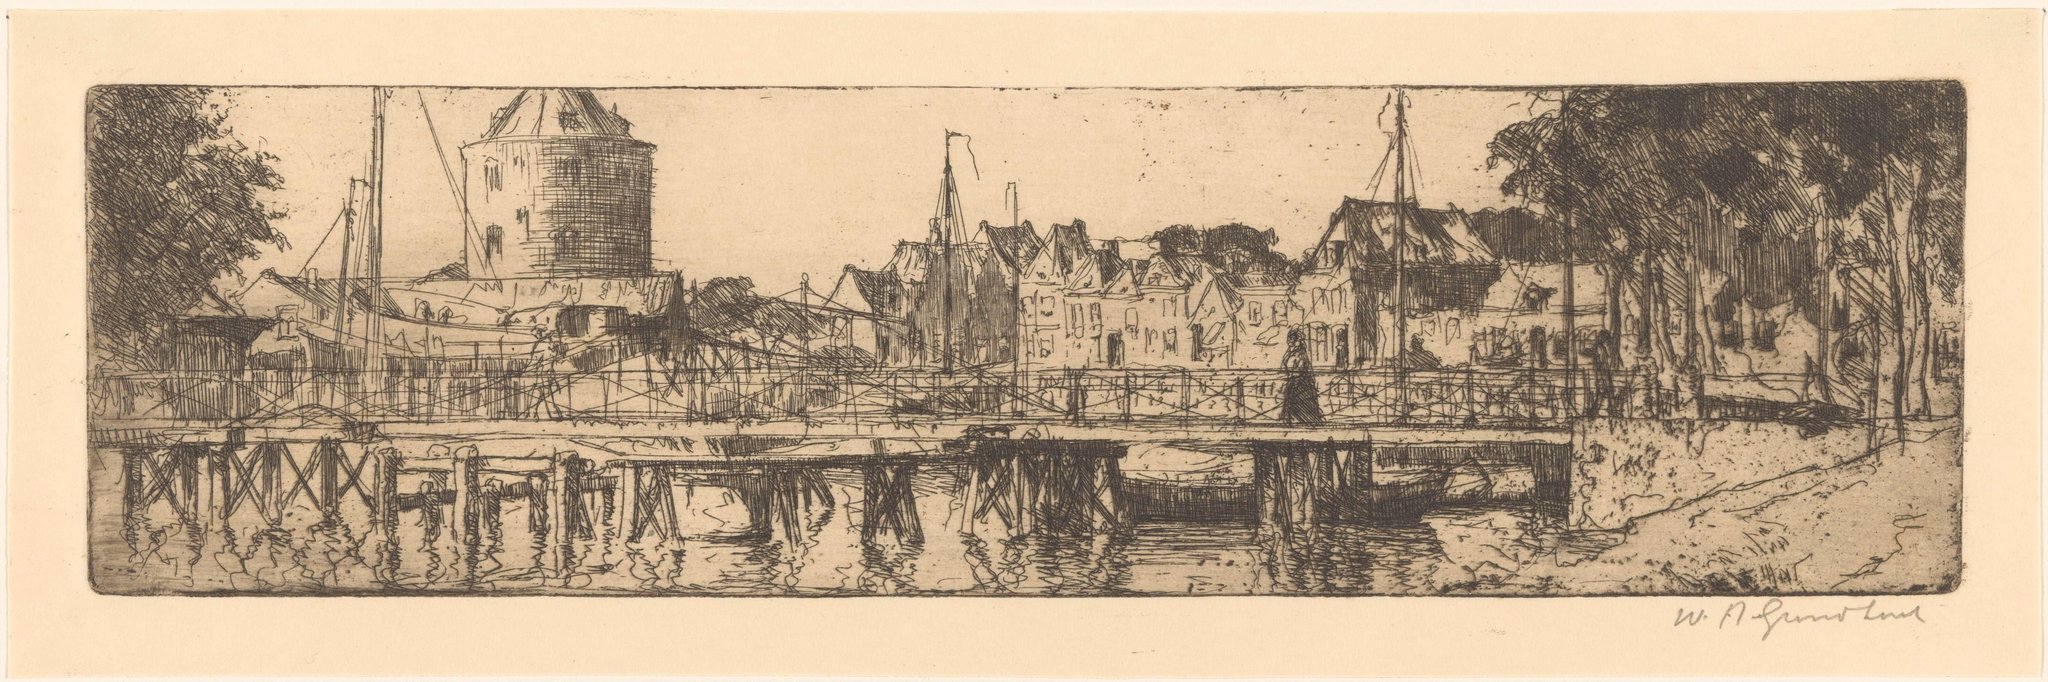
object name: print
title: Delft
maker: willem adrianus grondhout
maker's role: draughtsman, painter, print maker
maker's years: 1878-1934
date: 1888-1931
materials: paper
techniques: etching, intaglio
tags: harbour, canals, waters (in city), enkhuizen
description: De Oude Haven van Enkhuizen met de Leugenbrug en afgemeerde schepen. Links op de achtergrond de Drommedaris, de zuidelijke toegangspoort van de stad. Het stadsgezicht op de prent is een spiegelbeeldige weergave van de realiteit.